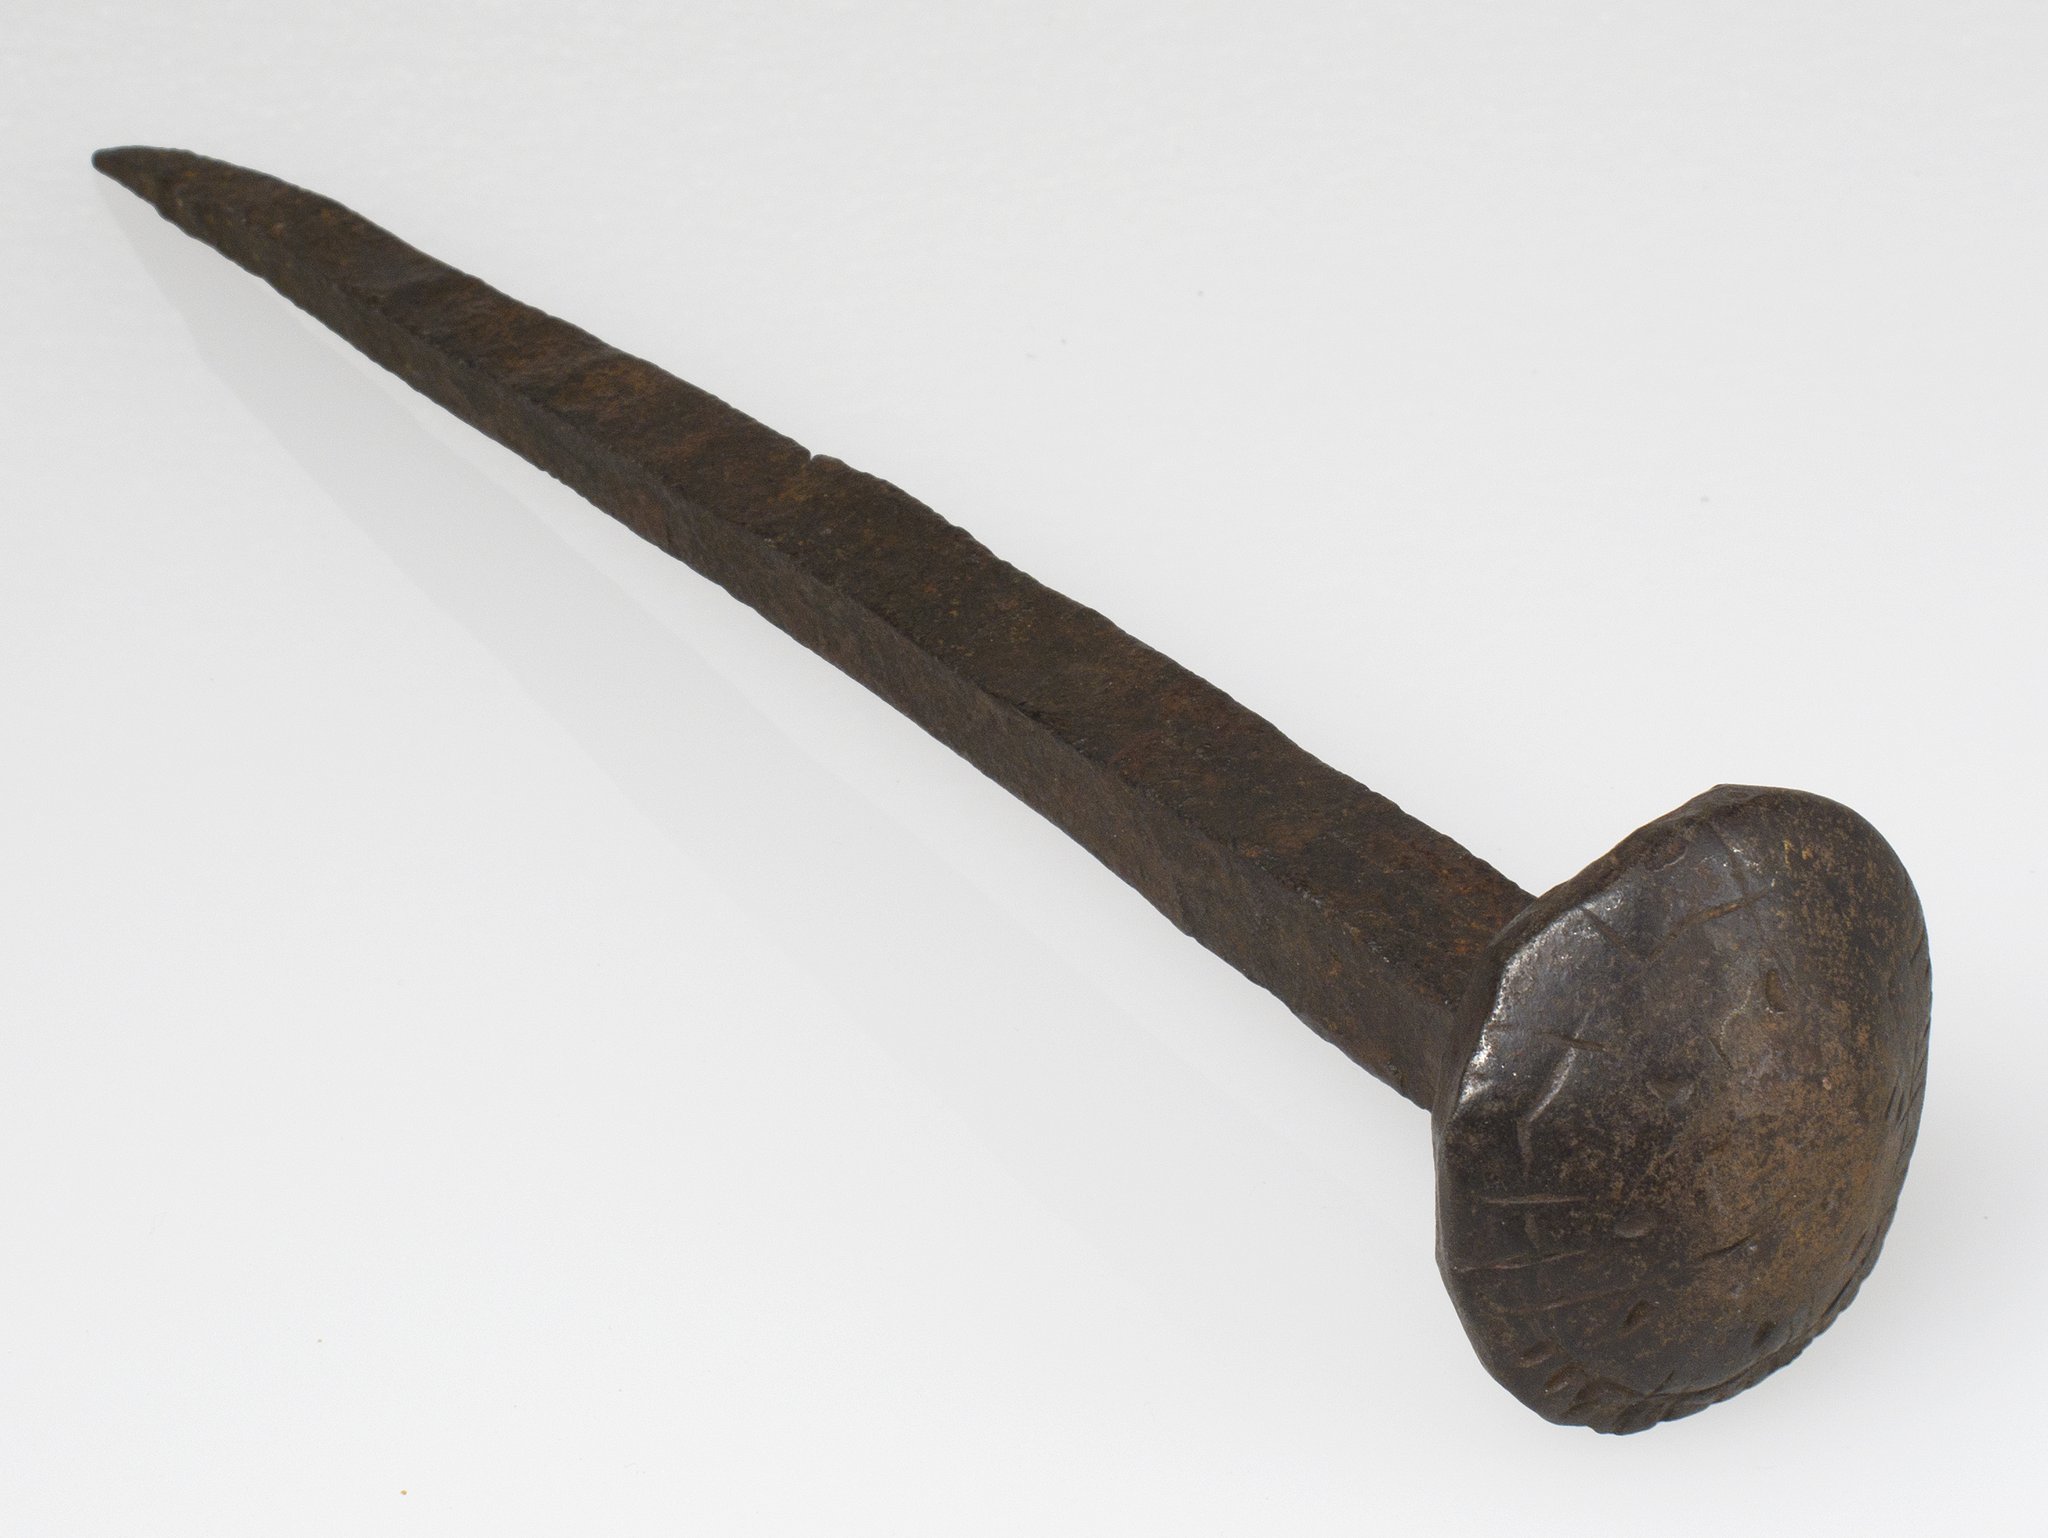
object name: nail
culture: european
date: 1401-1600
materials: iron